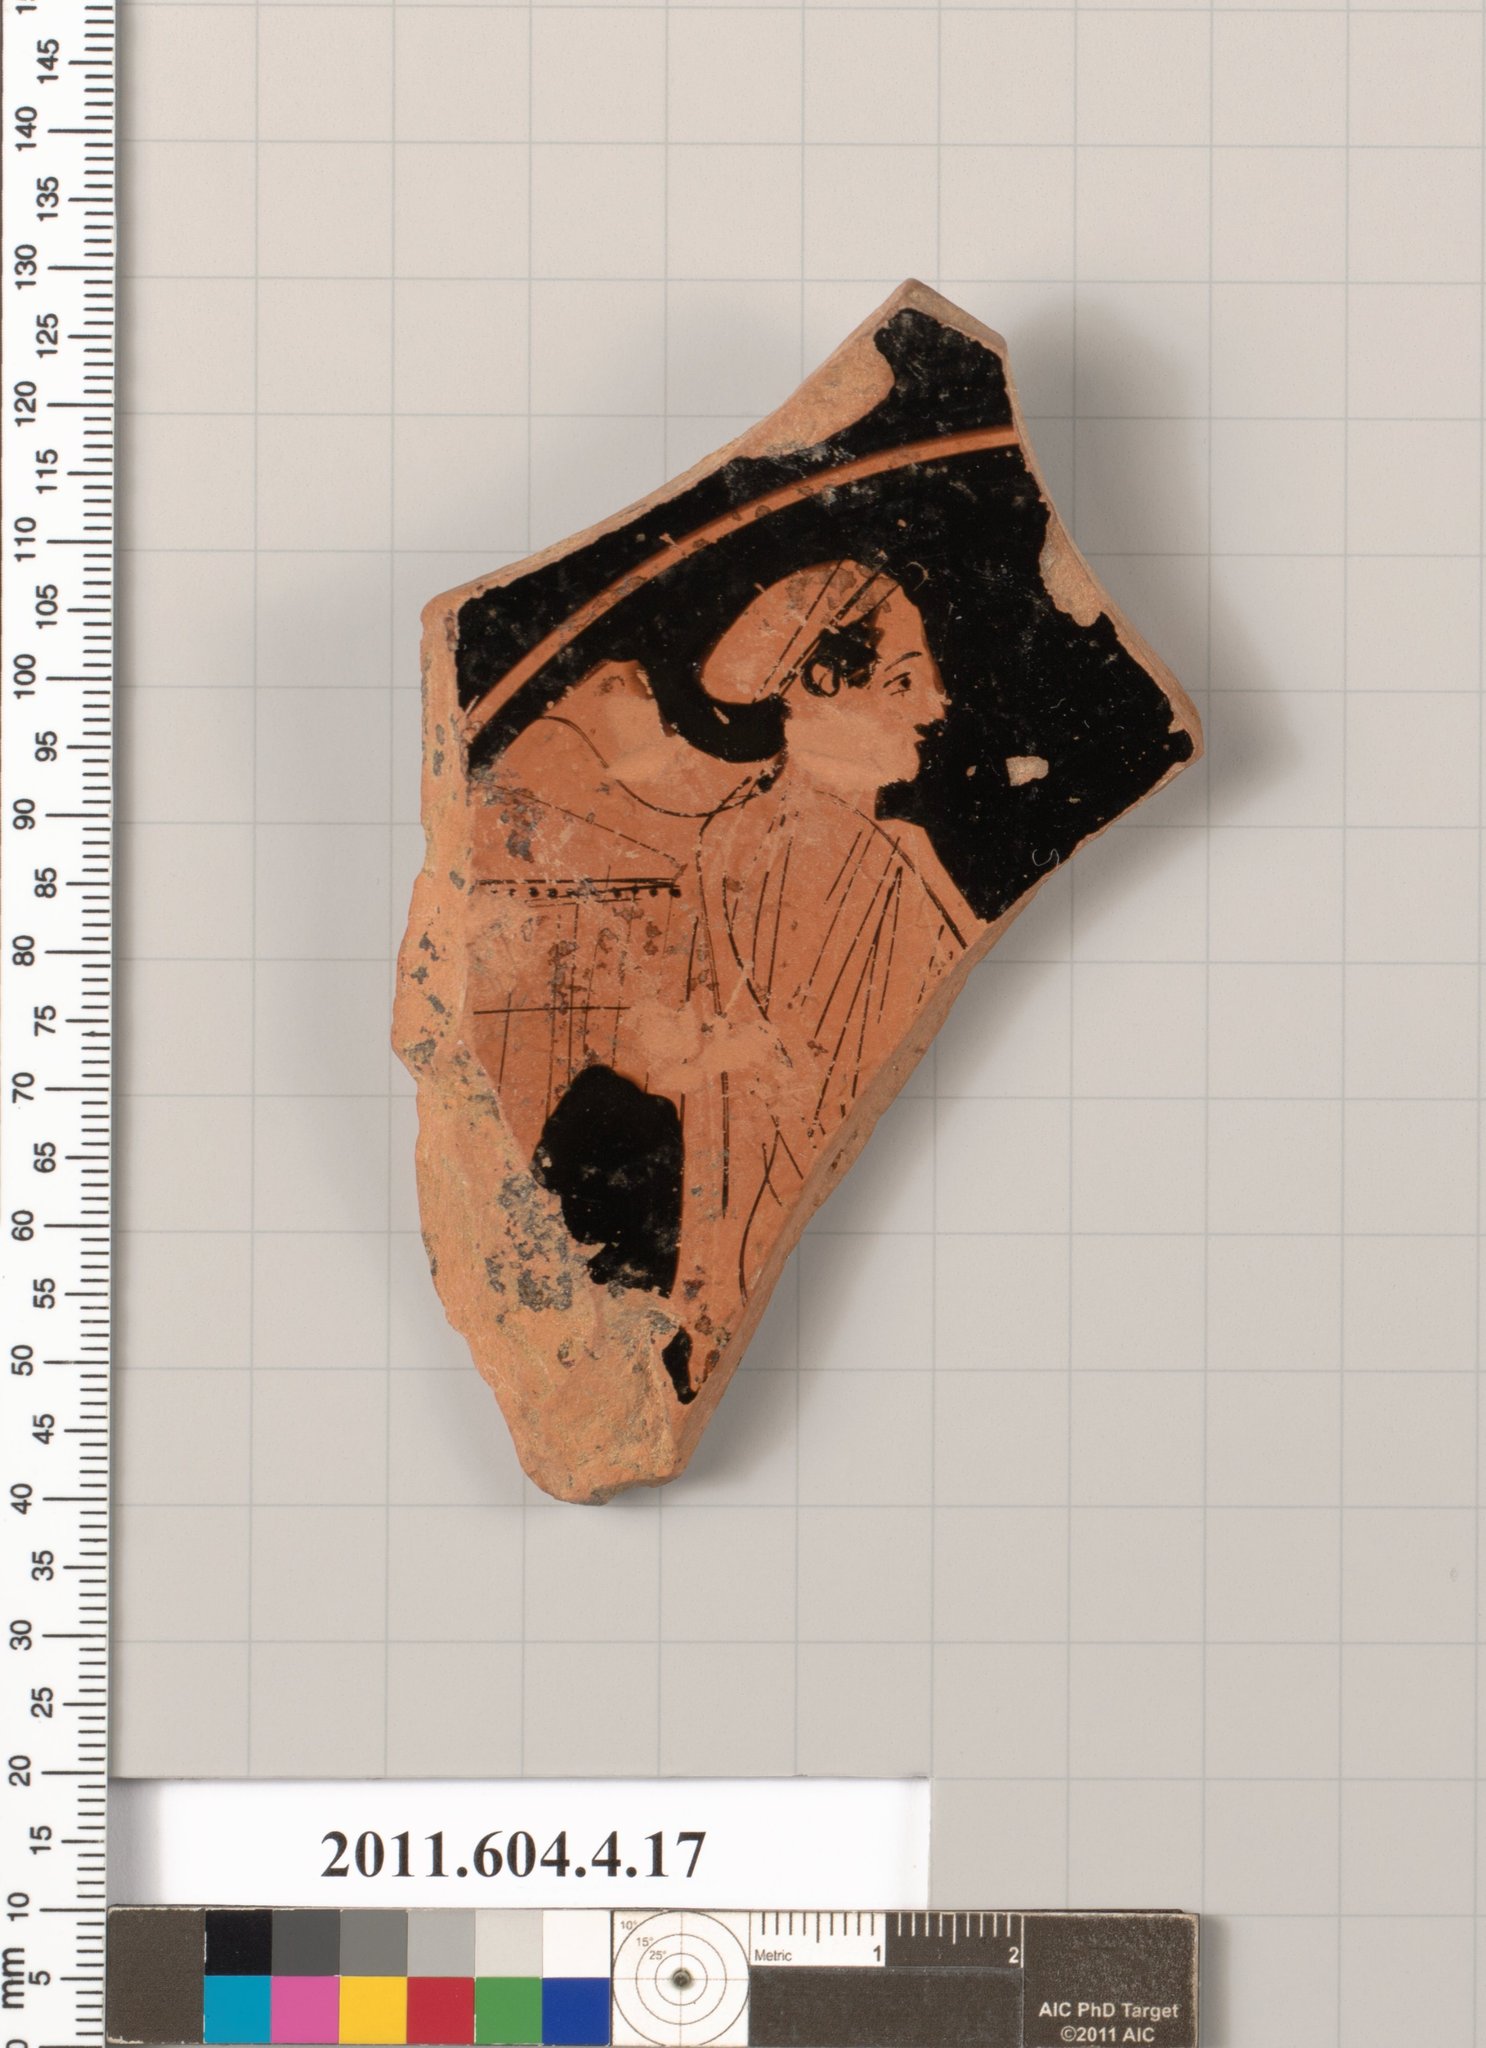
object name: kylix fragment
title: Terracotta fragment of a stemless kylix (drinking cup)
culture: greek, attic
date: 467-435 BCE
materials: terracotta